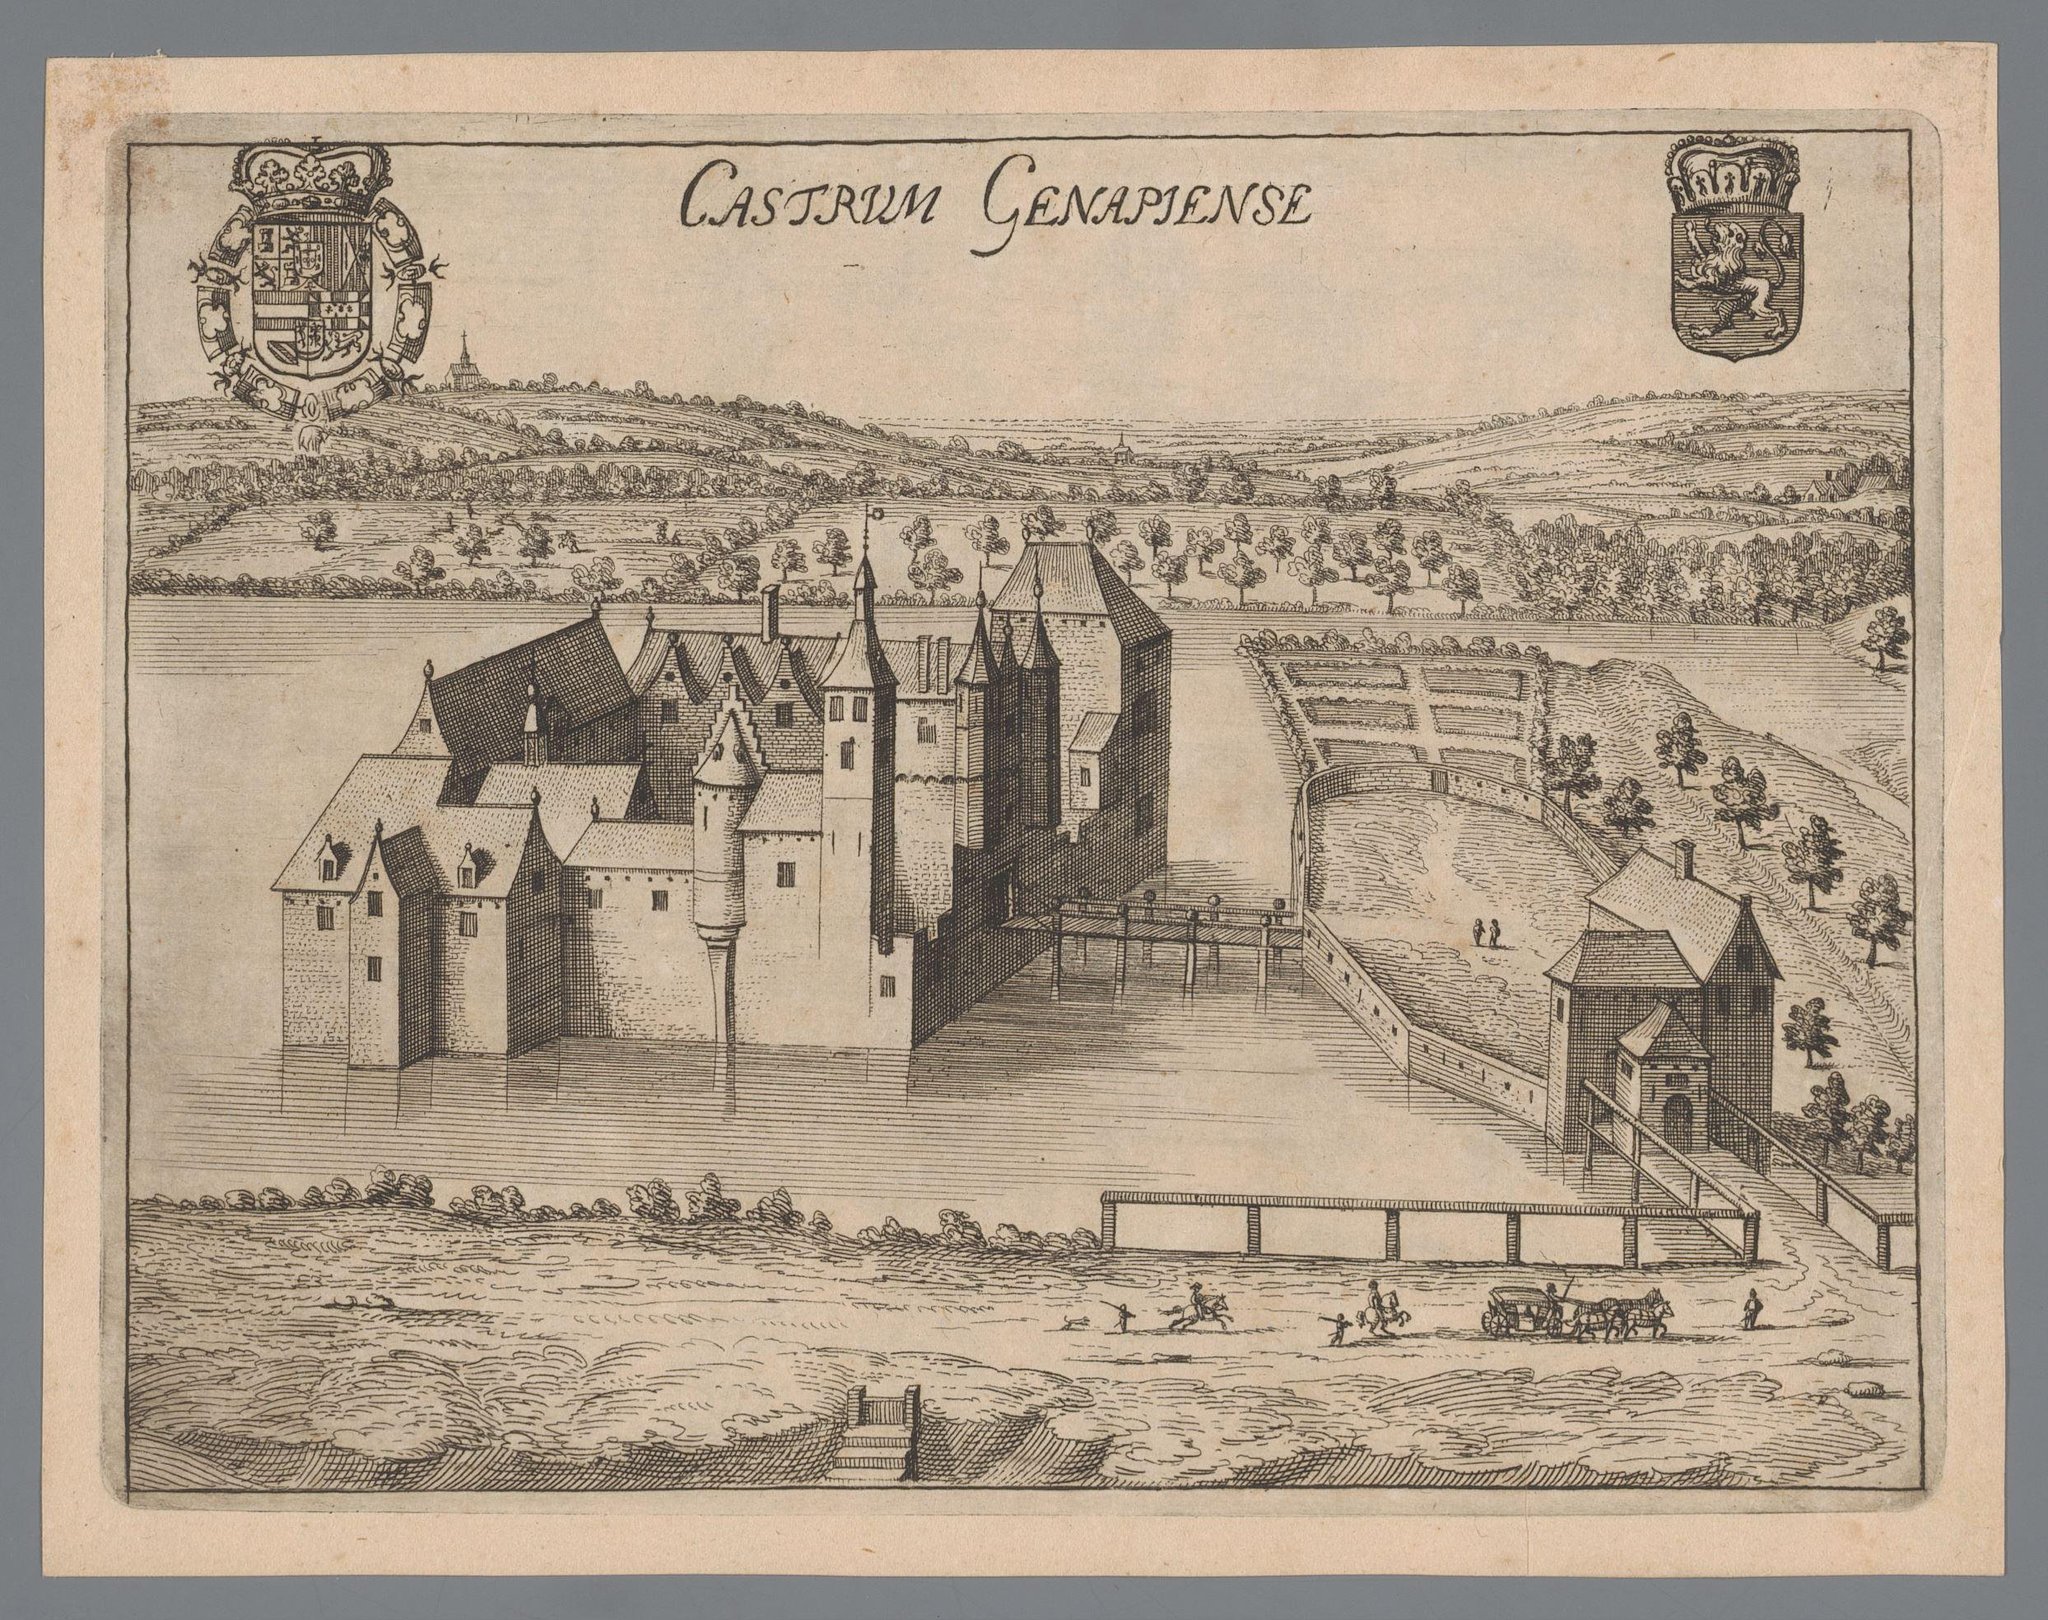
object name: print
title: Gezicht op het kasteel van Genappe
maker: Anonymous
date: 1650-1750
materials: paper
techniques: engraving, etching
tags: castle, landscape with tower or castle, genappe